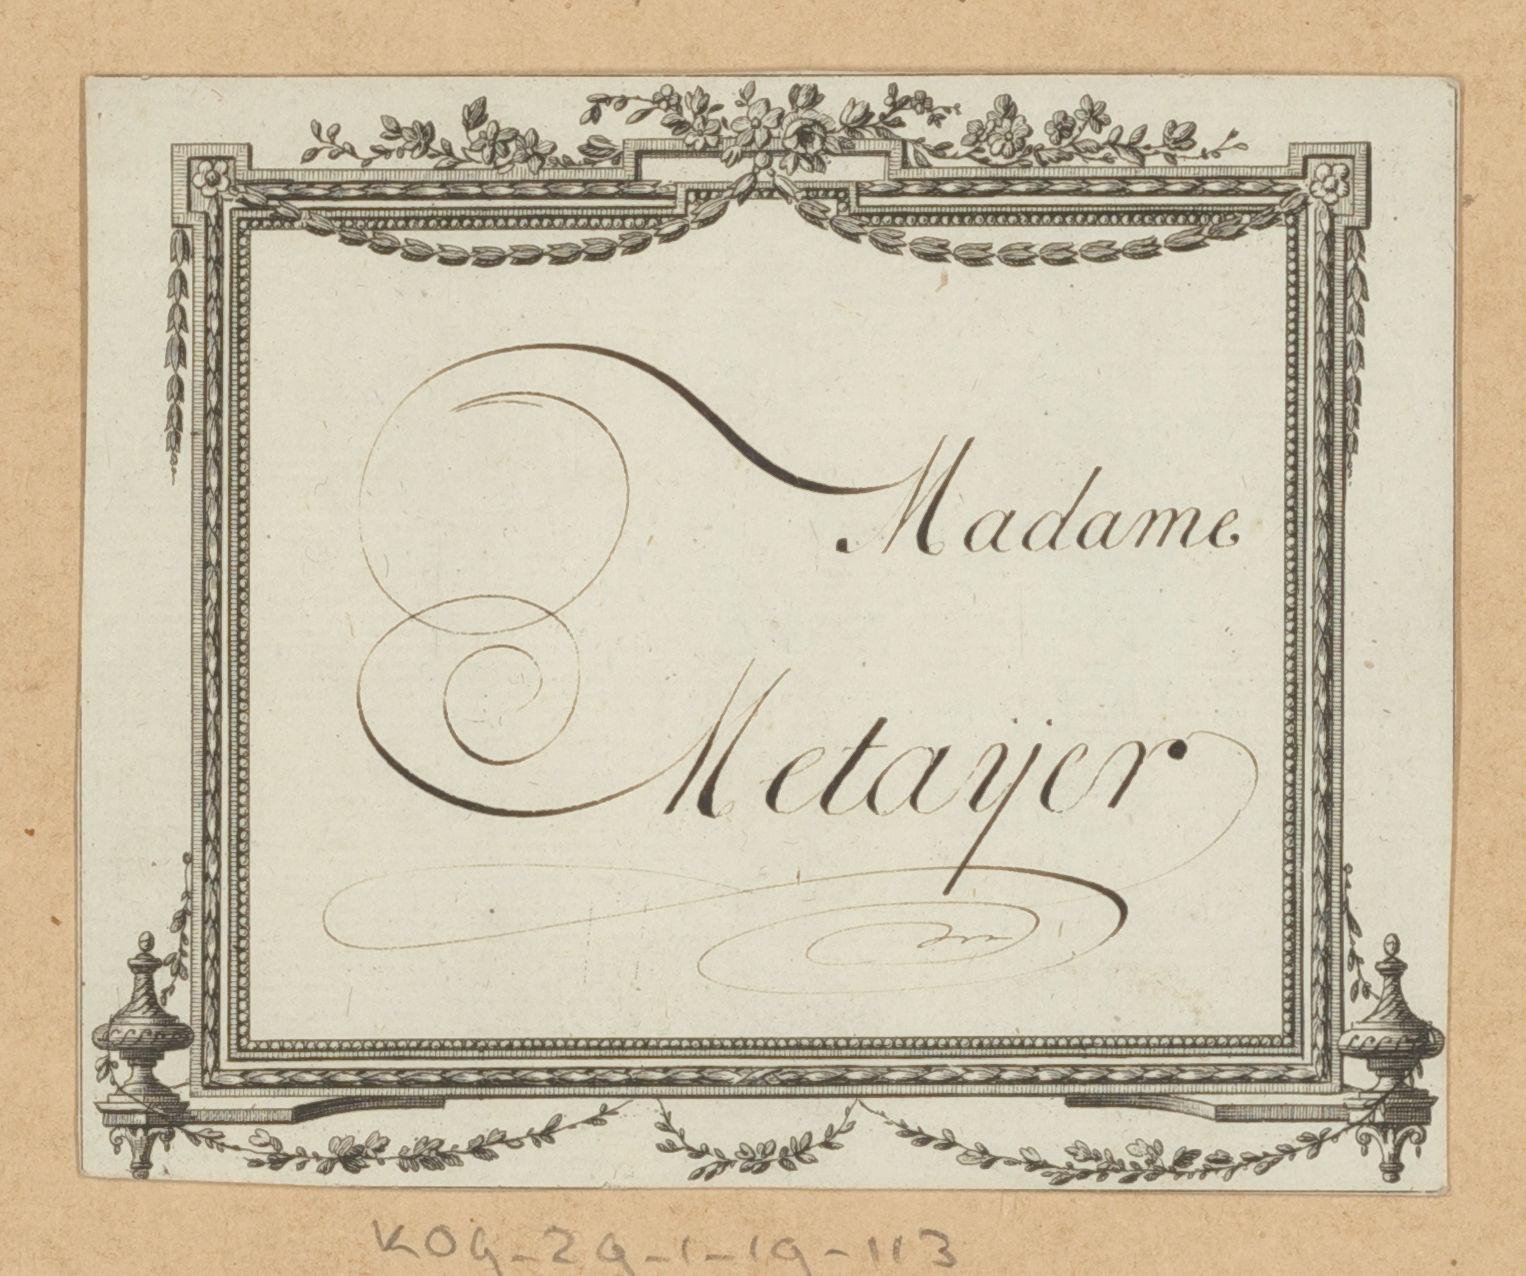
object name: print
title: Bruiloftskaart voor 'Madame Metayer'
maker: Anonymous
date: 1790-1799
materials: paper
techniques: engraving, etching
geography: netherlands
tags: antoinette bernard, wedding feast, wedding meal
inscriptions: collector's mark: Lugt 1641, collector's mark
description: Naamkaartje voor Antoinette Bernard, de echtgenote van Louis Metayer, te gebruiken bij de tafelindeling bij een bruiloftsmaal. Onderdeel van een groep van bruilofts- en invitatiekaartjes van de families Bernard en Metayer. Onderwerpsrubrieken binnen de Atlas Zeden en Gewoonten: Des Menschen Begin, Midden en Einde. Bruiloft en huwelijk.